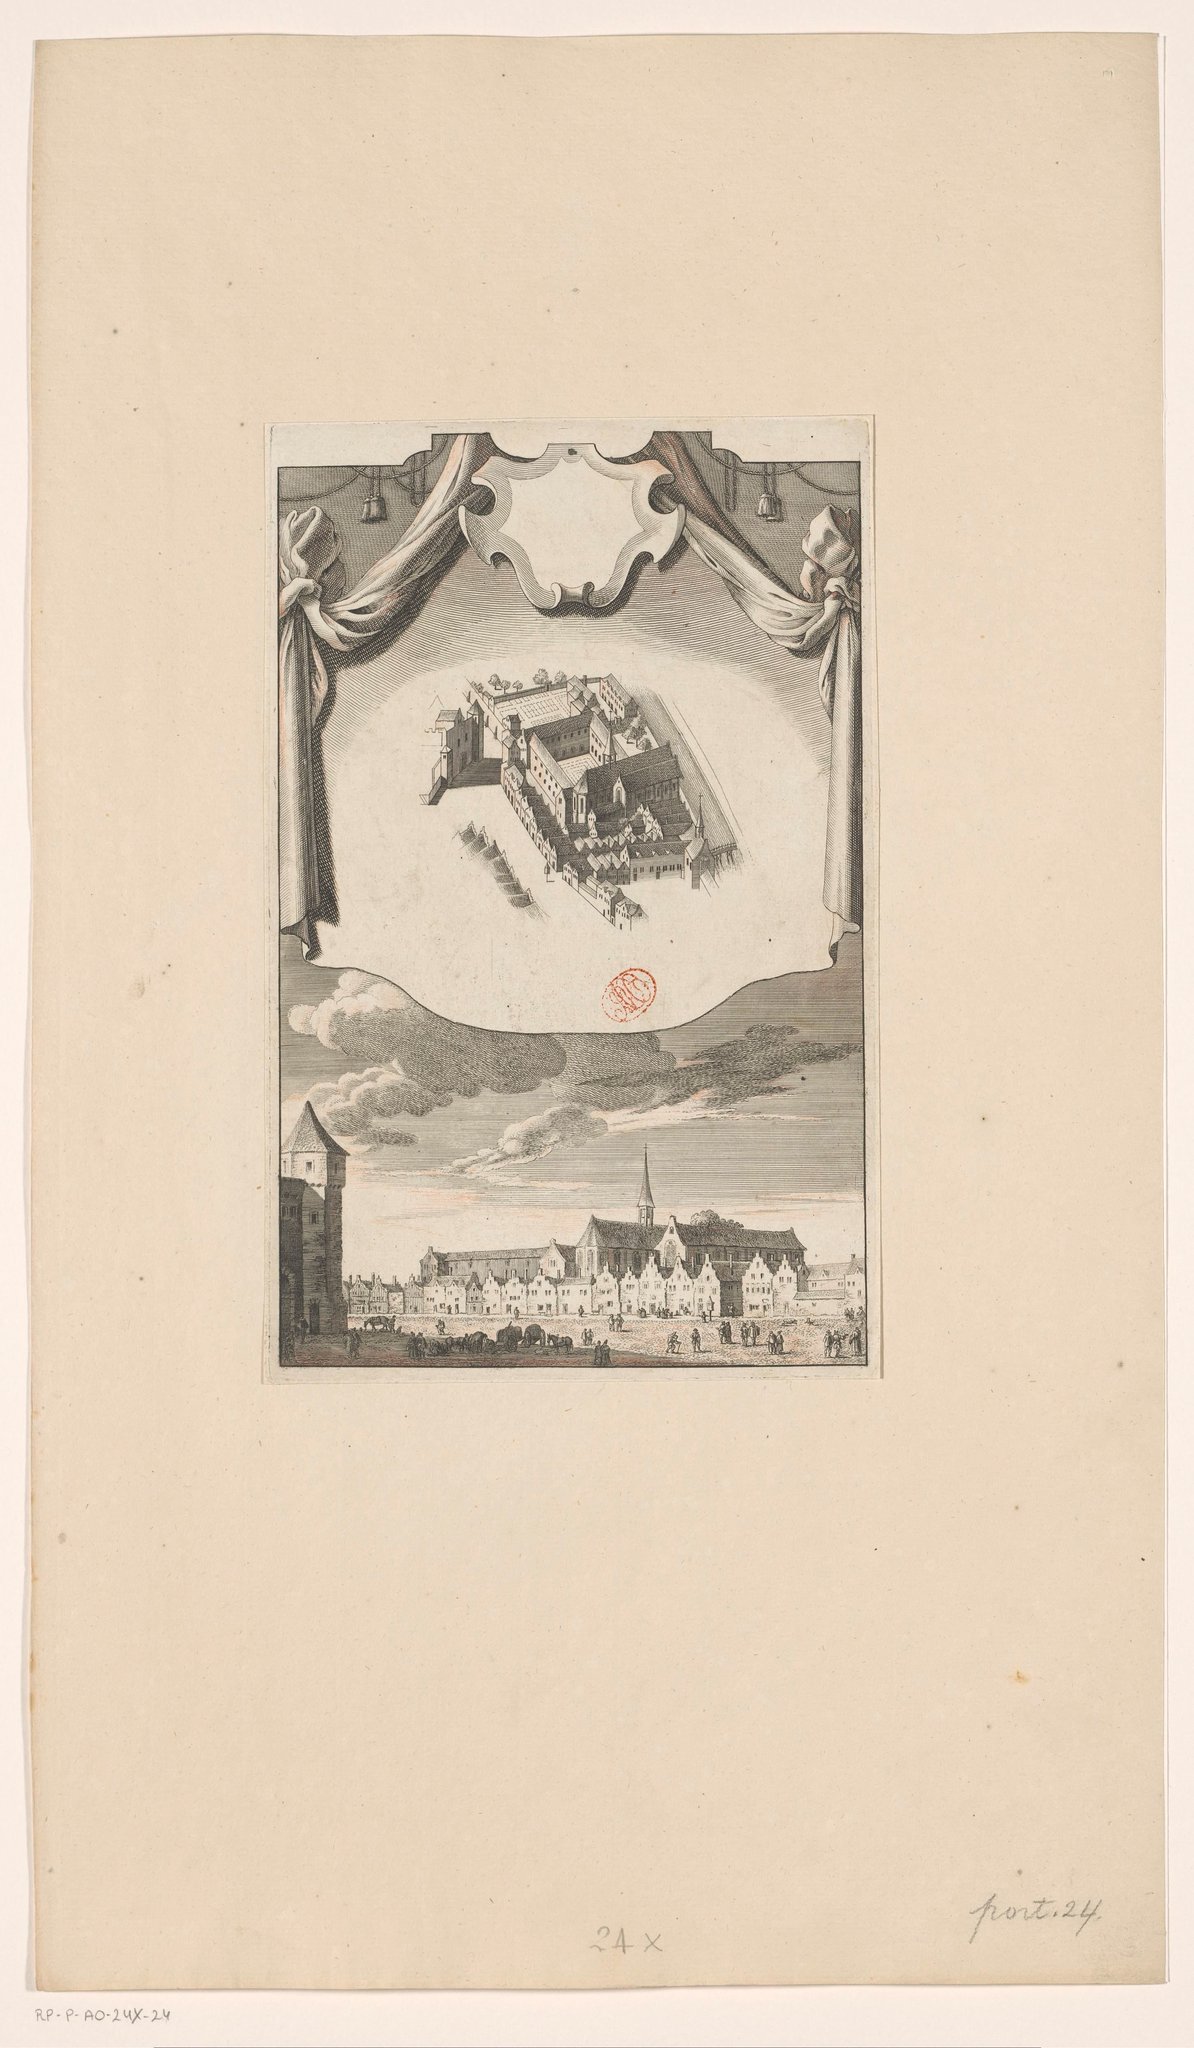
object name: print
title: Gezichten op het Minderbroedersklooster te Amsterdam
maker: Anonymous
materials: chalk, paper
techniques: engraving, etching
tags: abbey, monastery, convent ~ roman catholic church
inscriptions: collector's mark: Lugt 2233, collector's mark: Lugt 195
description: Latere staat van prent ook gebruikt in: Wagenaar, Jan. Amsterdam, in zyne opkomst, aanwas, geschiedenissen (…). 3 delen [folio-uitgave]. Amsterdam: Isaak Tirion en Yntema & Tieboel, 1760-1767, dl. 1 (Isaac Tirion, 1760). Zie RP-P-AO-24X-23 voor tweede staat. Dat de prent de situatie rond 1544 weergeeft gaat terug op het feit dat voor het maken van deze en andere prenten van kloosters en kerken van voor de Alteratie (1578) is uitgegaan van de plattegrond van Cornelis Anthonisz. uit 1544 (zie RP-P-OB-70.399 en RP-P-AO-20-15).